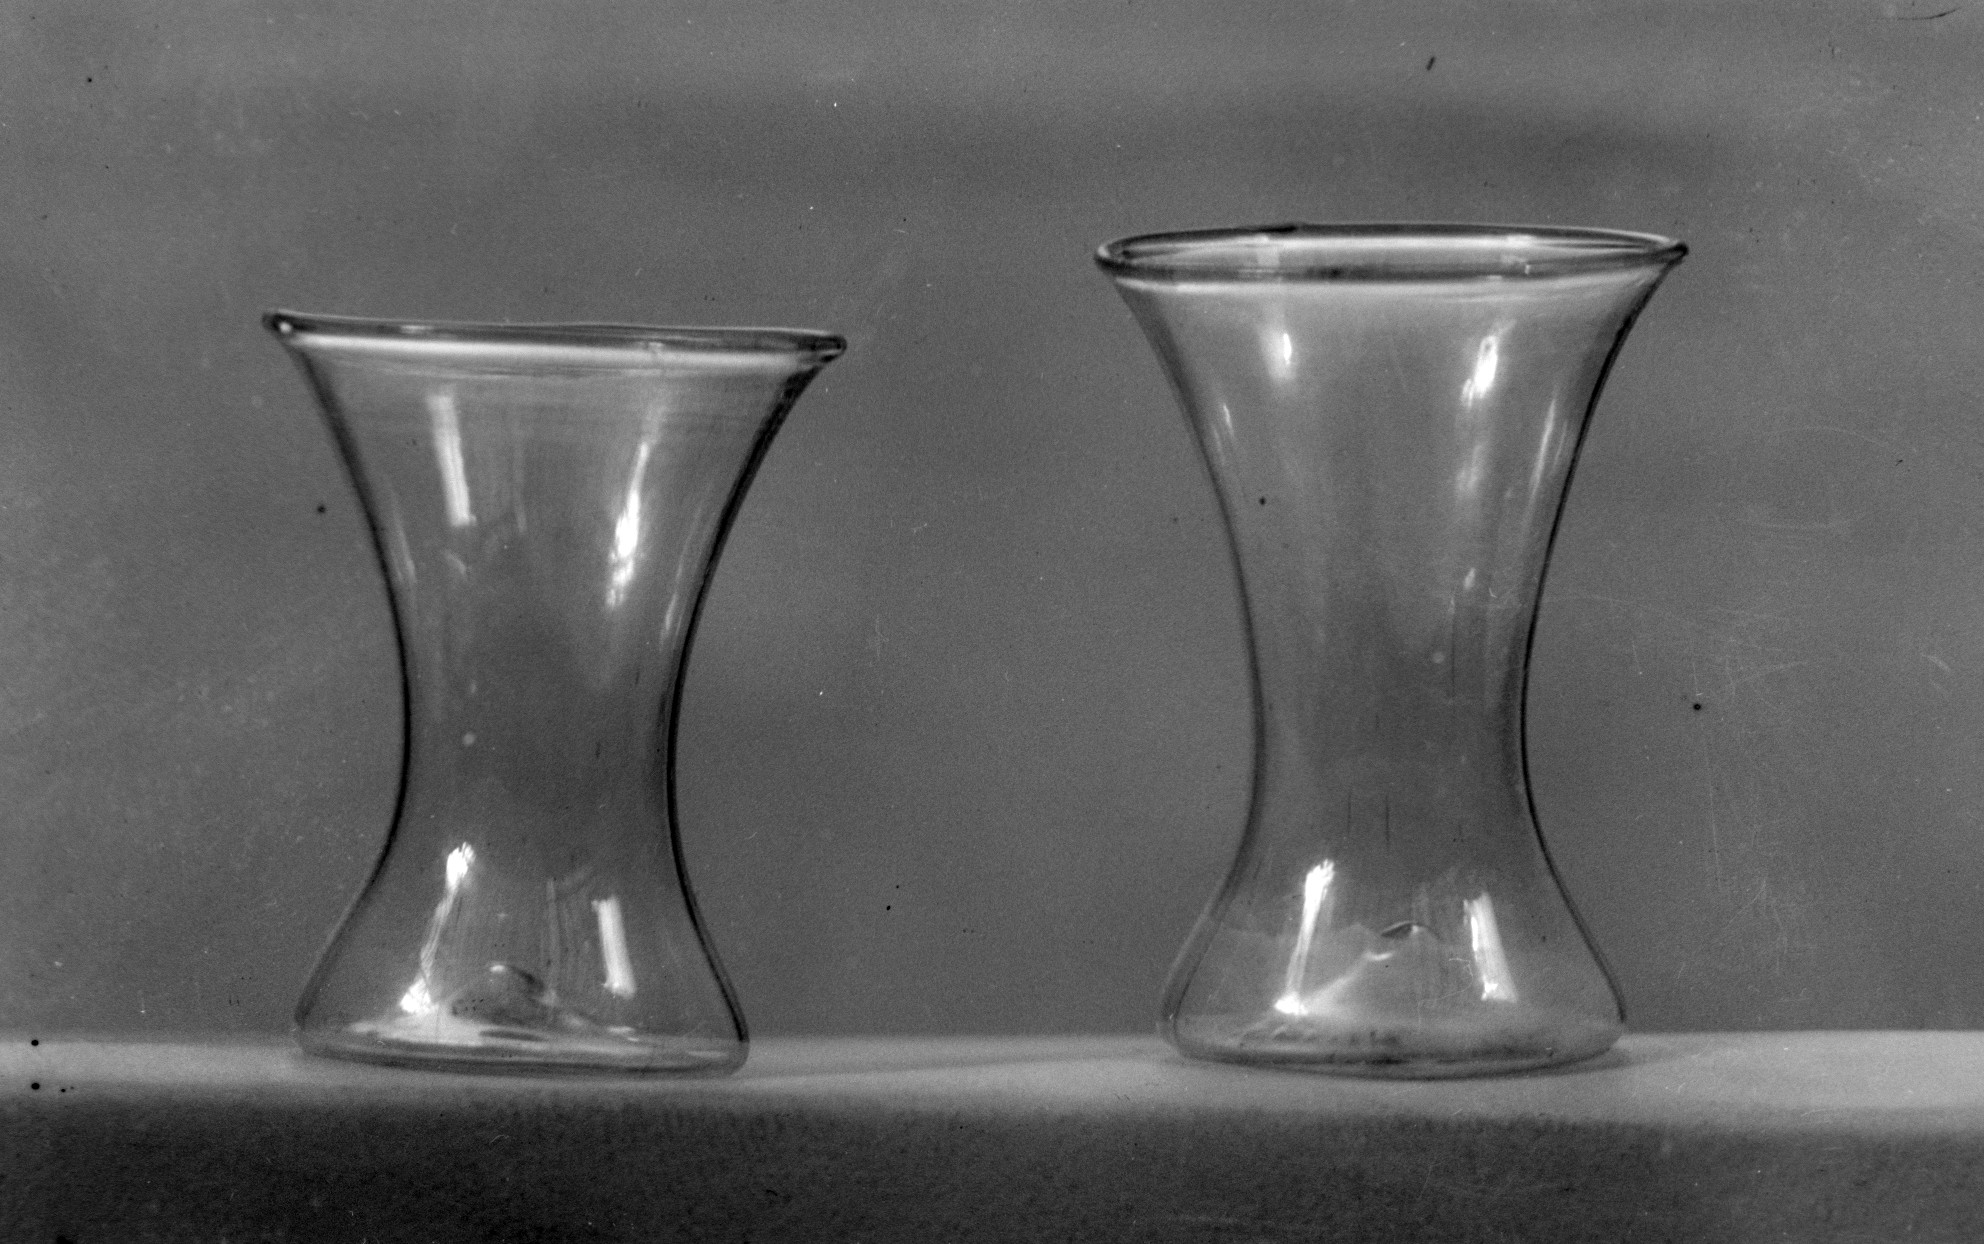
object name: beaker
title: Miniature beaker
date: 1801-1833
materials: glass